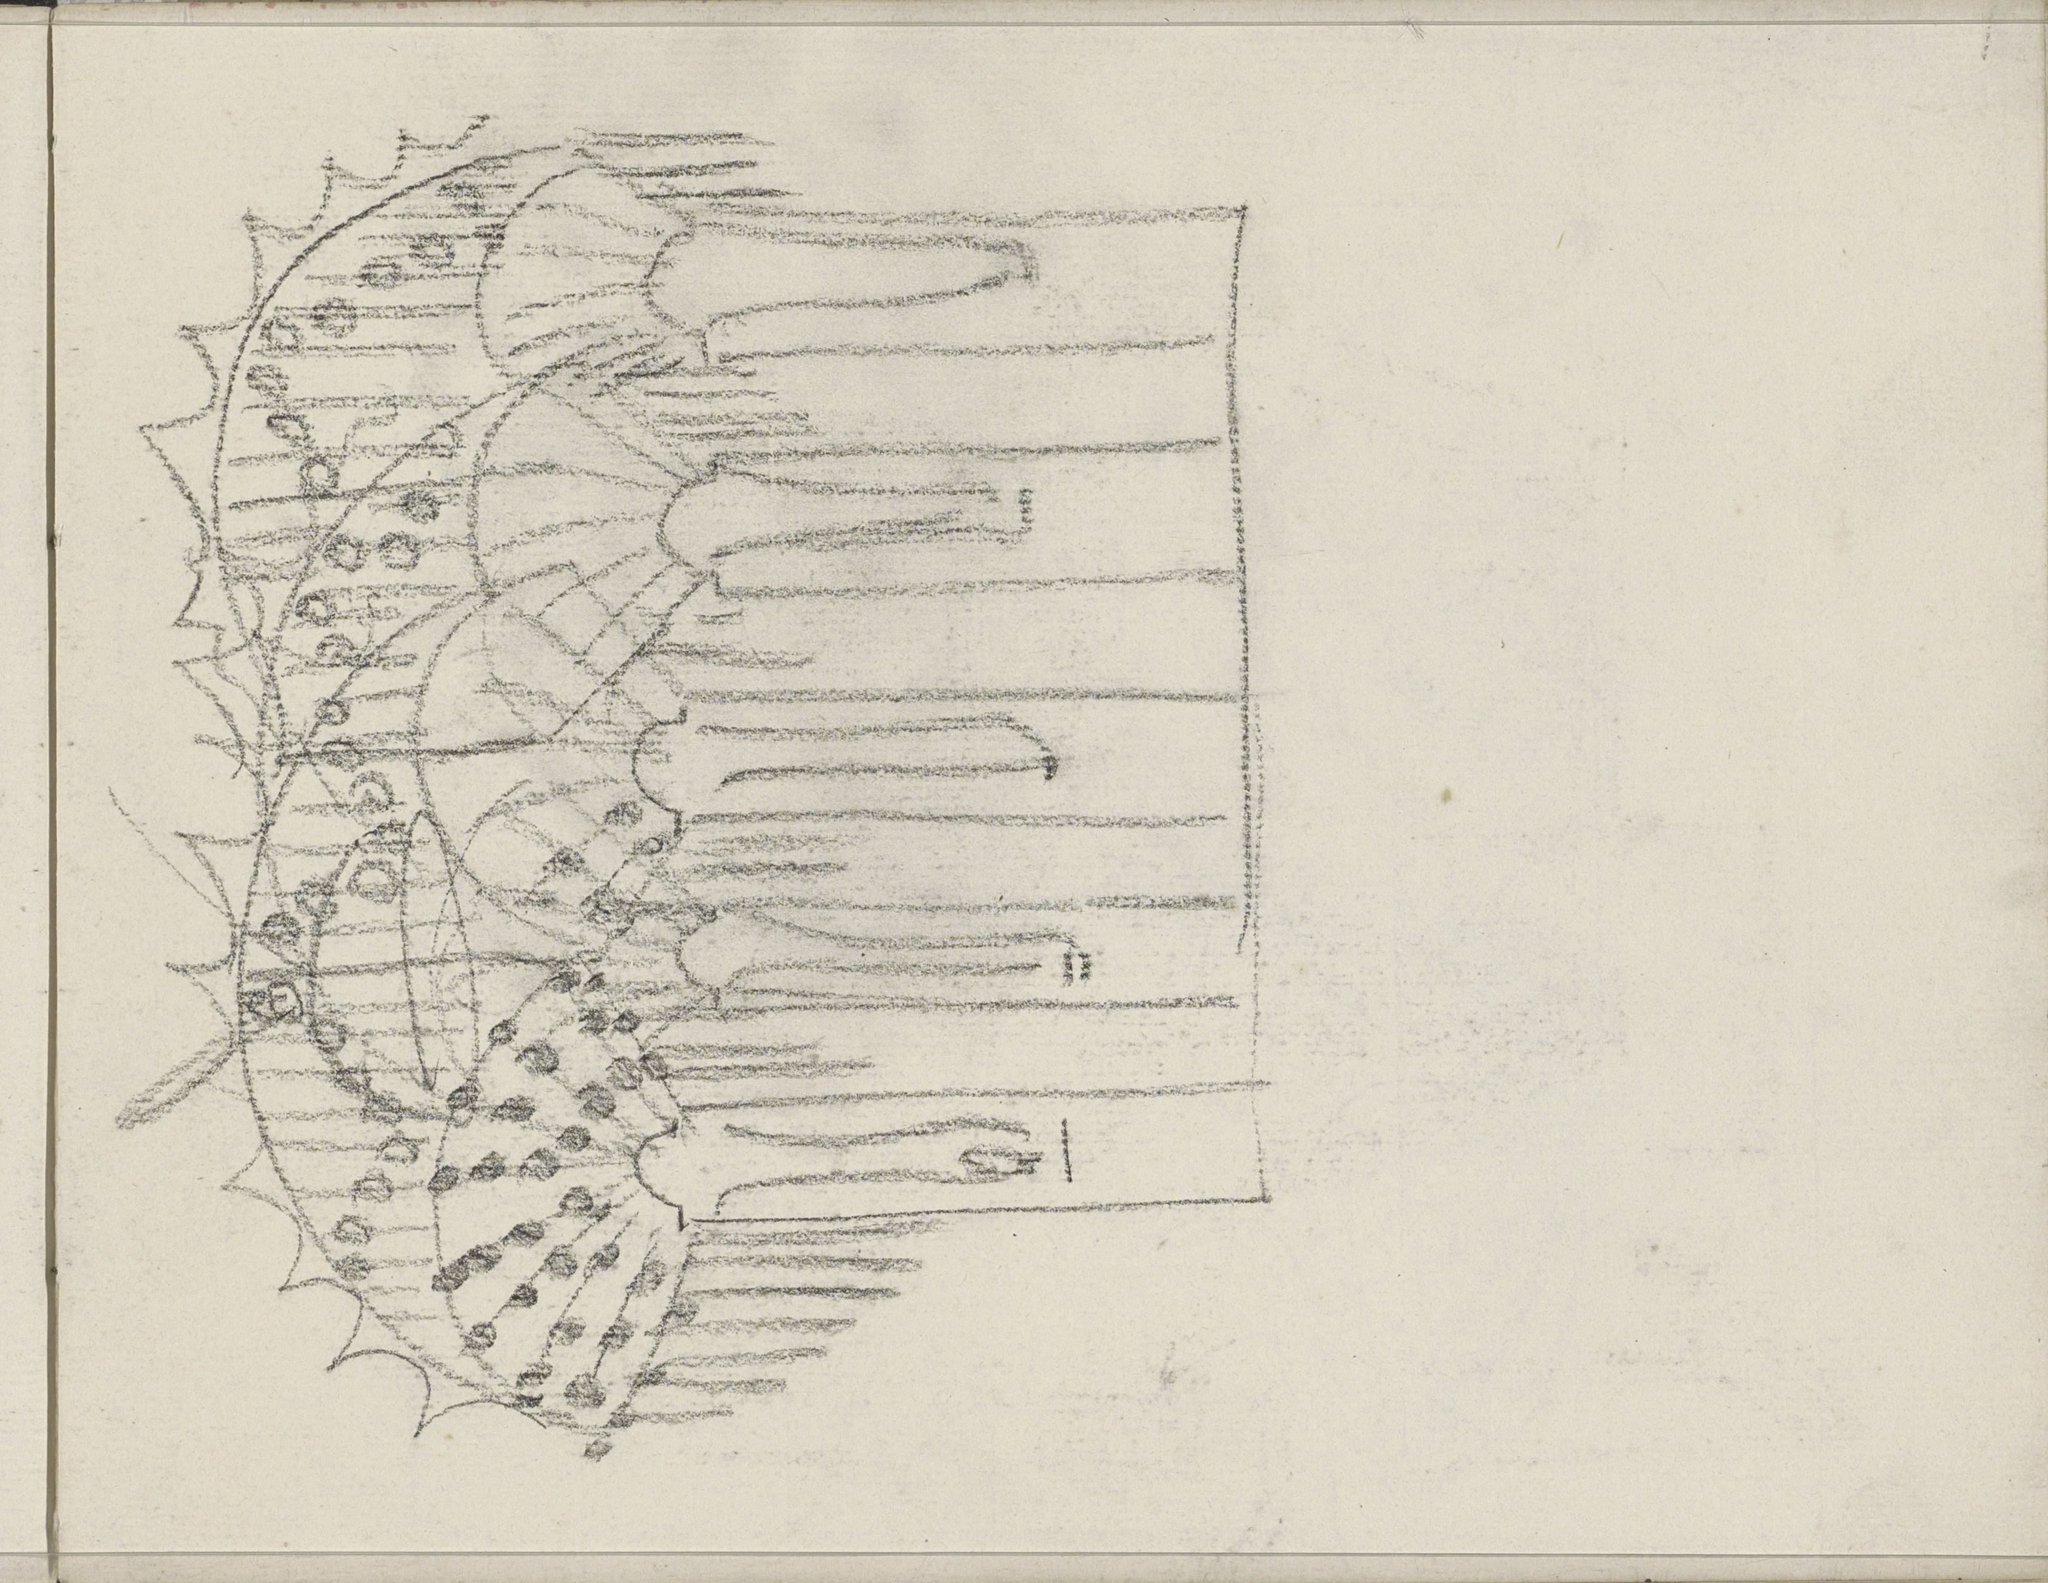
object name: sketchbook leaf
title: Ornament met bogen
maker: carel adolph lion cachet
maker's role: draughtsman, print maker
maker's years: 1864-1945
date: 1896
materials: chalk, paper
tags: ornaments ~ art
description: Blad 29 recto uit een schetsboek met 44 bladen.